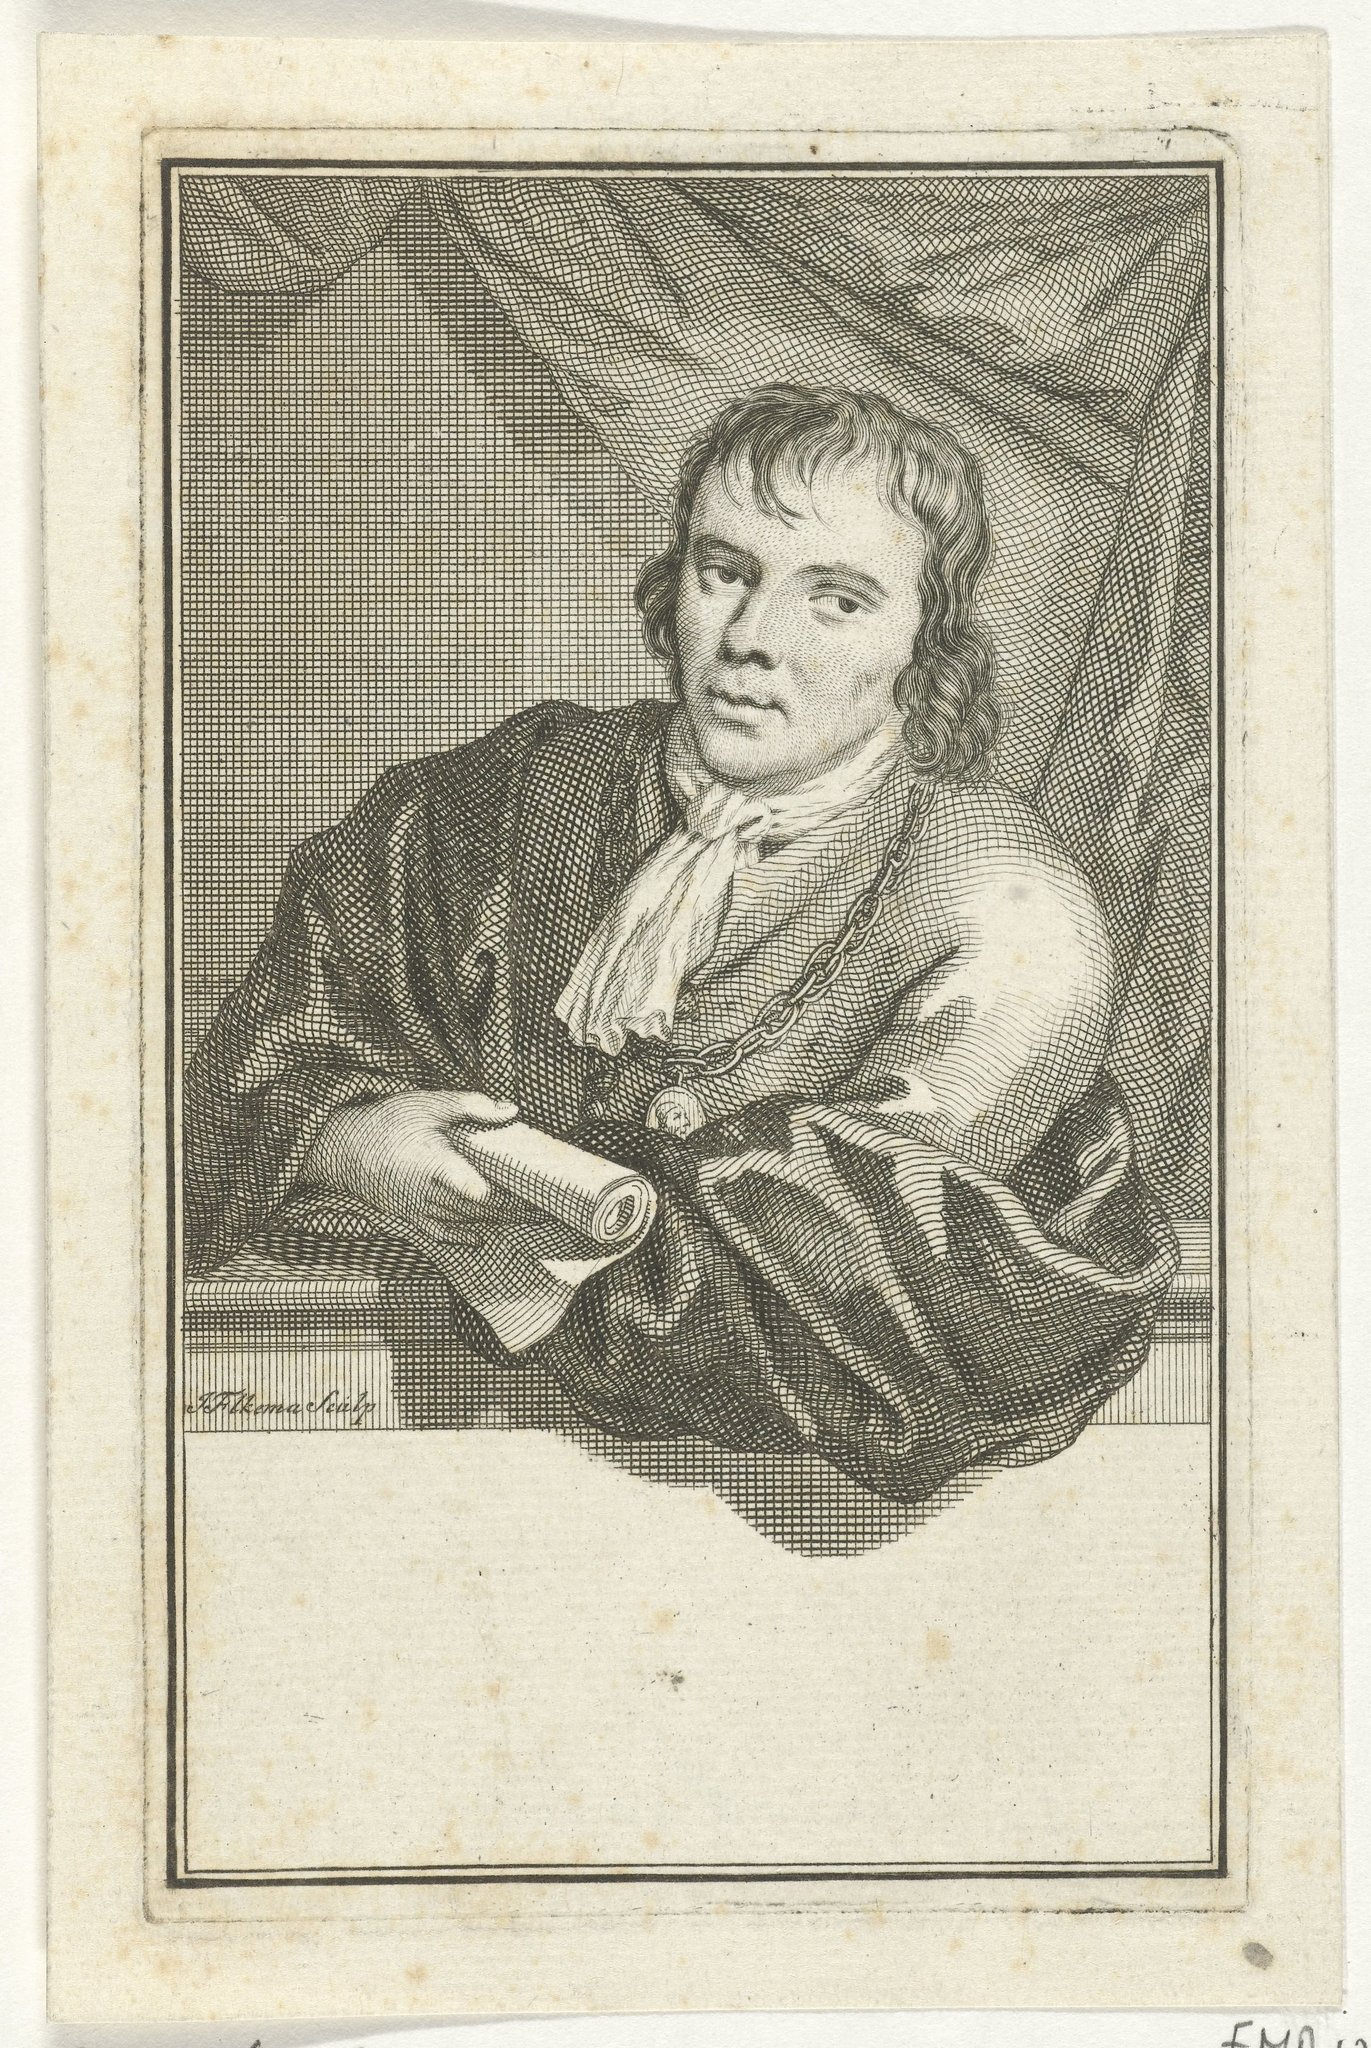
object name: print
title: Portret van Reyer Anslo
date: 1702-1767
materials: paper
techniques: engraving, etching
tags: reyer anslo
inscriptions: collector's mark: Lugt 2228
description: Portret ten halven lijve naar links van de letterkundige Reyer Anslo, blootshoofds. In zijn hand houdt Anslo een rol papier.